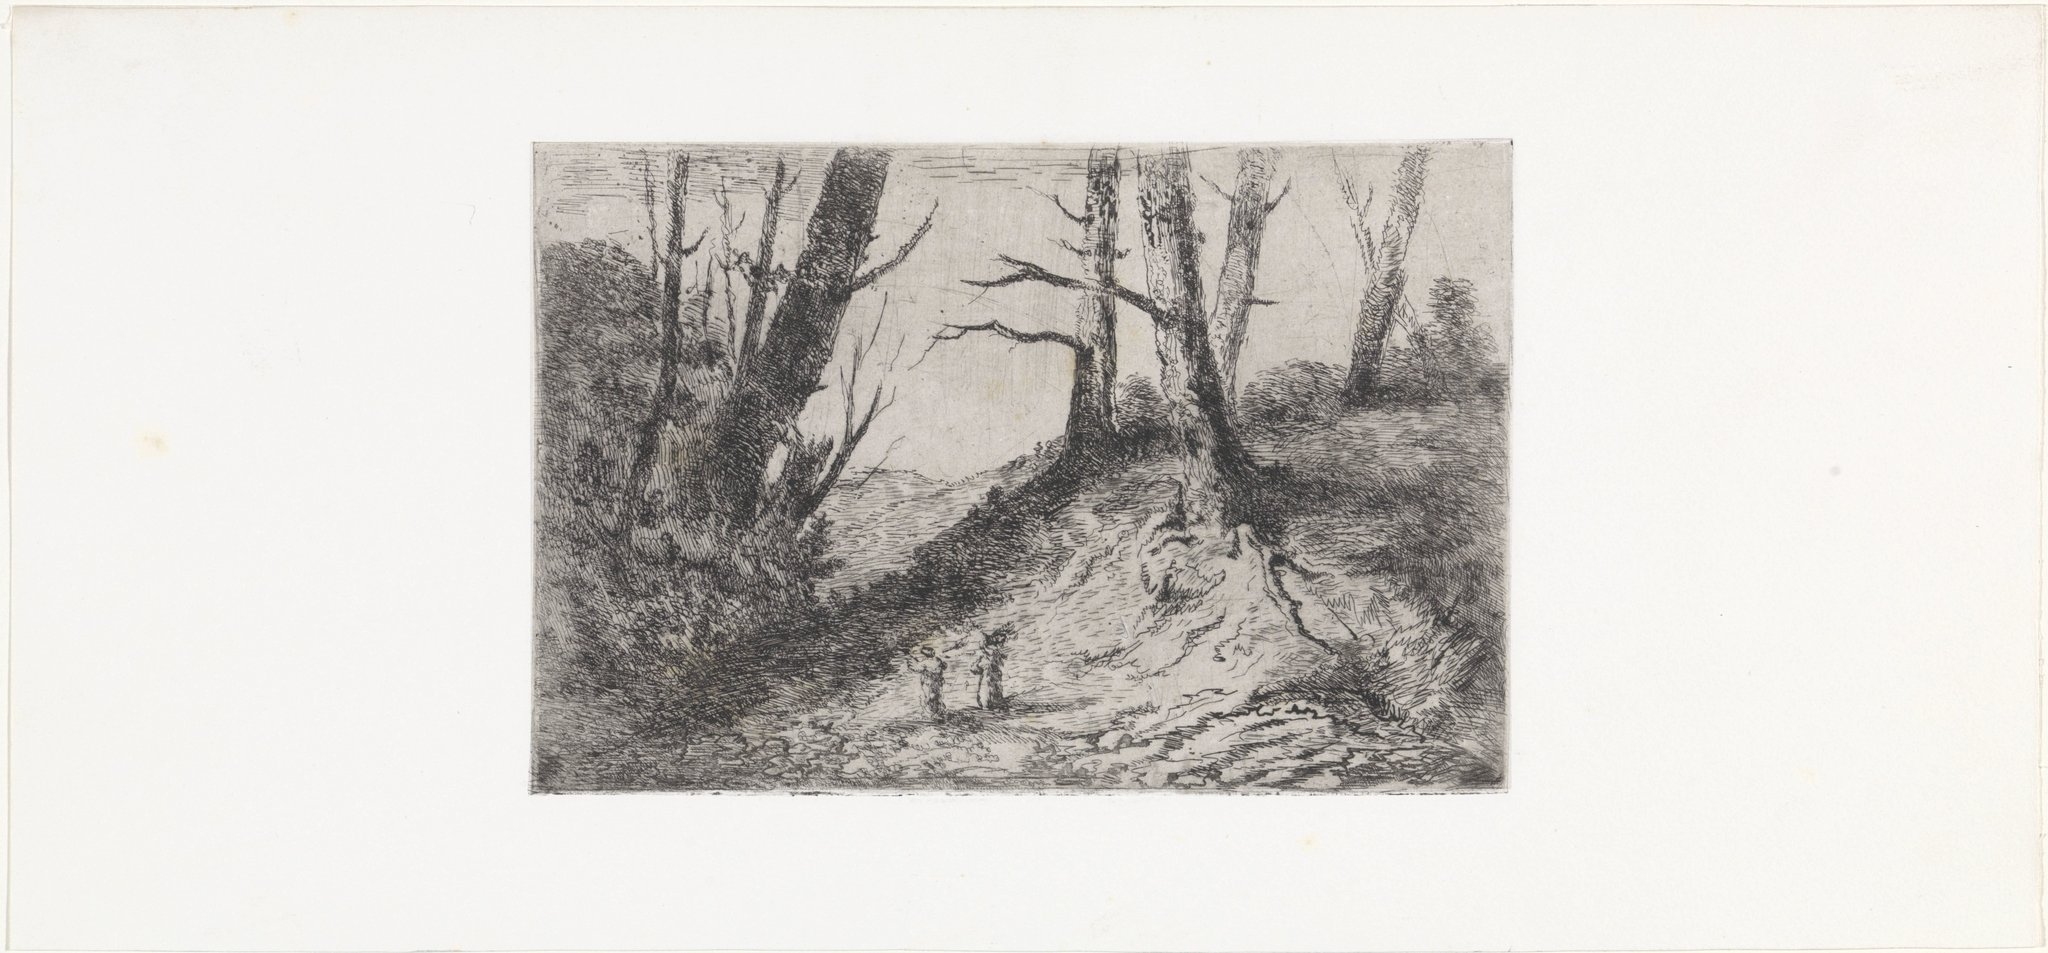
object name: print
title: Wandelaars op een pad omgeven door kale bomen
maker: arnoud schaepkens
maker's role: print maker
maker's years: 1816-1904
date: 1855-1904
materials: paper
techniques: drypoint, etching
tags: low hill country, trees, forest path or lane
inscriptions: collector's mark: Lugt 2228